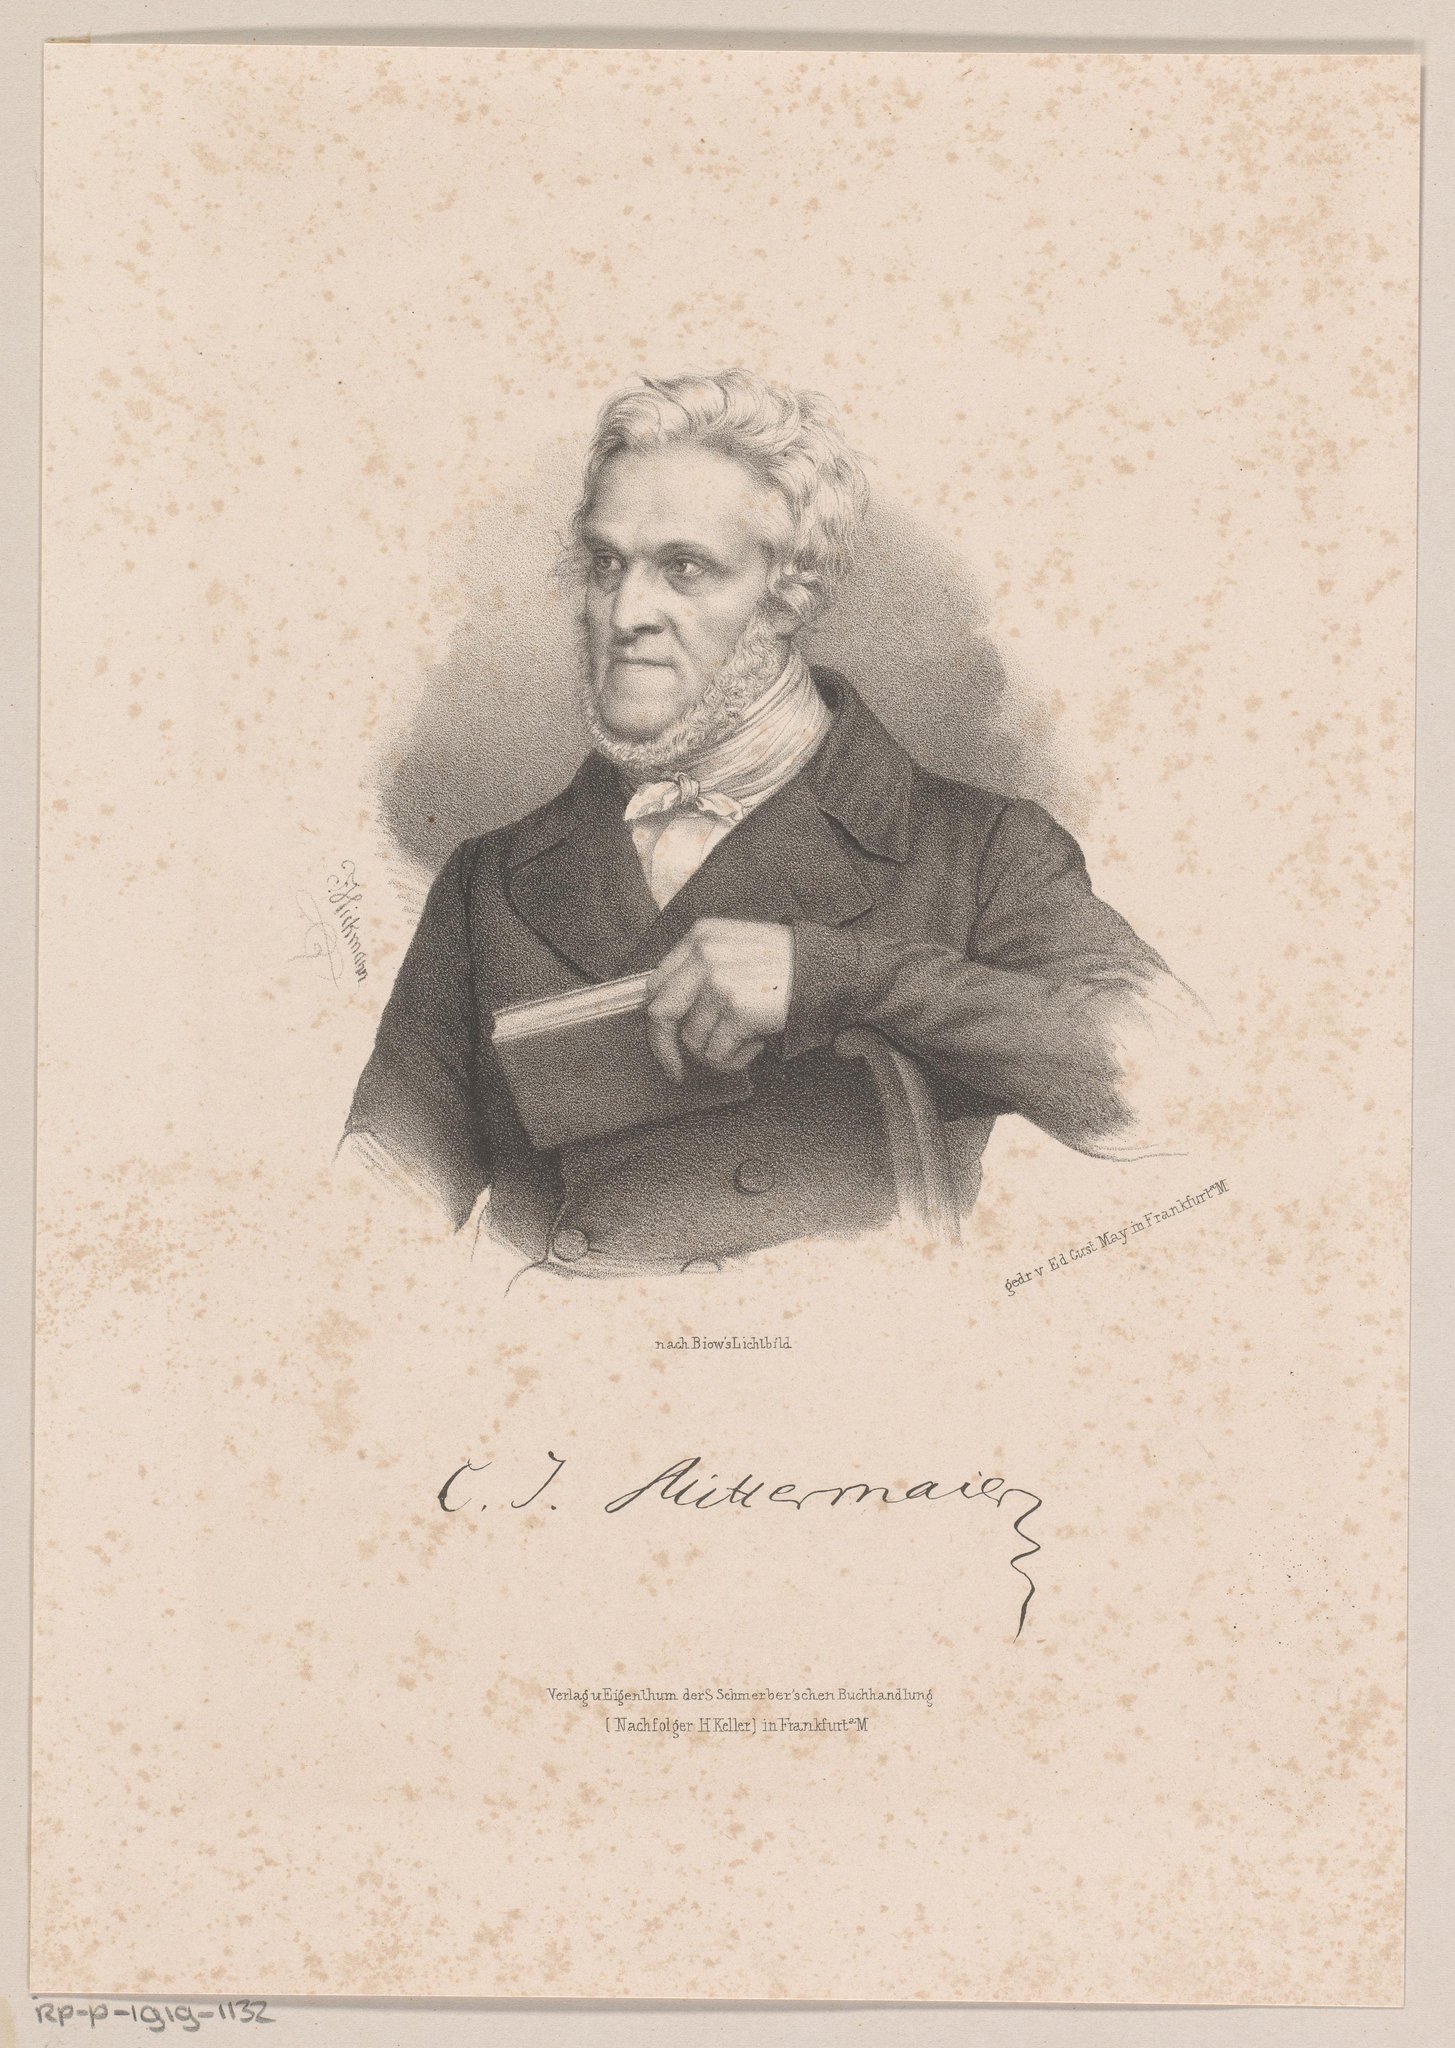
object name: print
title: Portret Karl Joseph Anton Mittermaier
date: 1845-1850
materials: paper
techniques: lithograph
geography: frankfurt am main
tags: historical persons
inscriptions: collector's mark: Lugt 2228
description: Met facsimile signatuur van de geportretteerde.